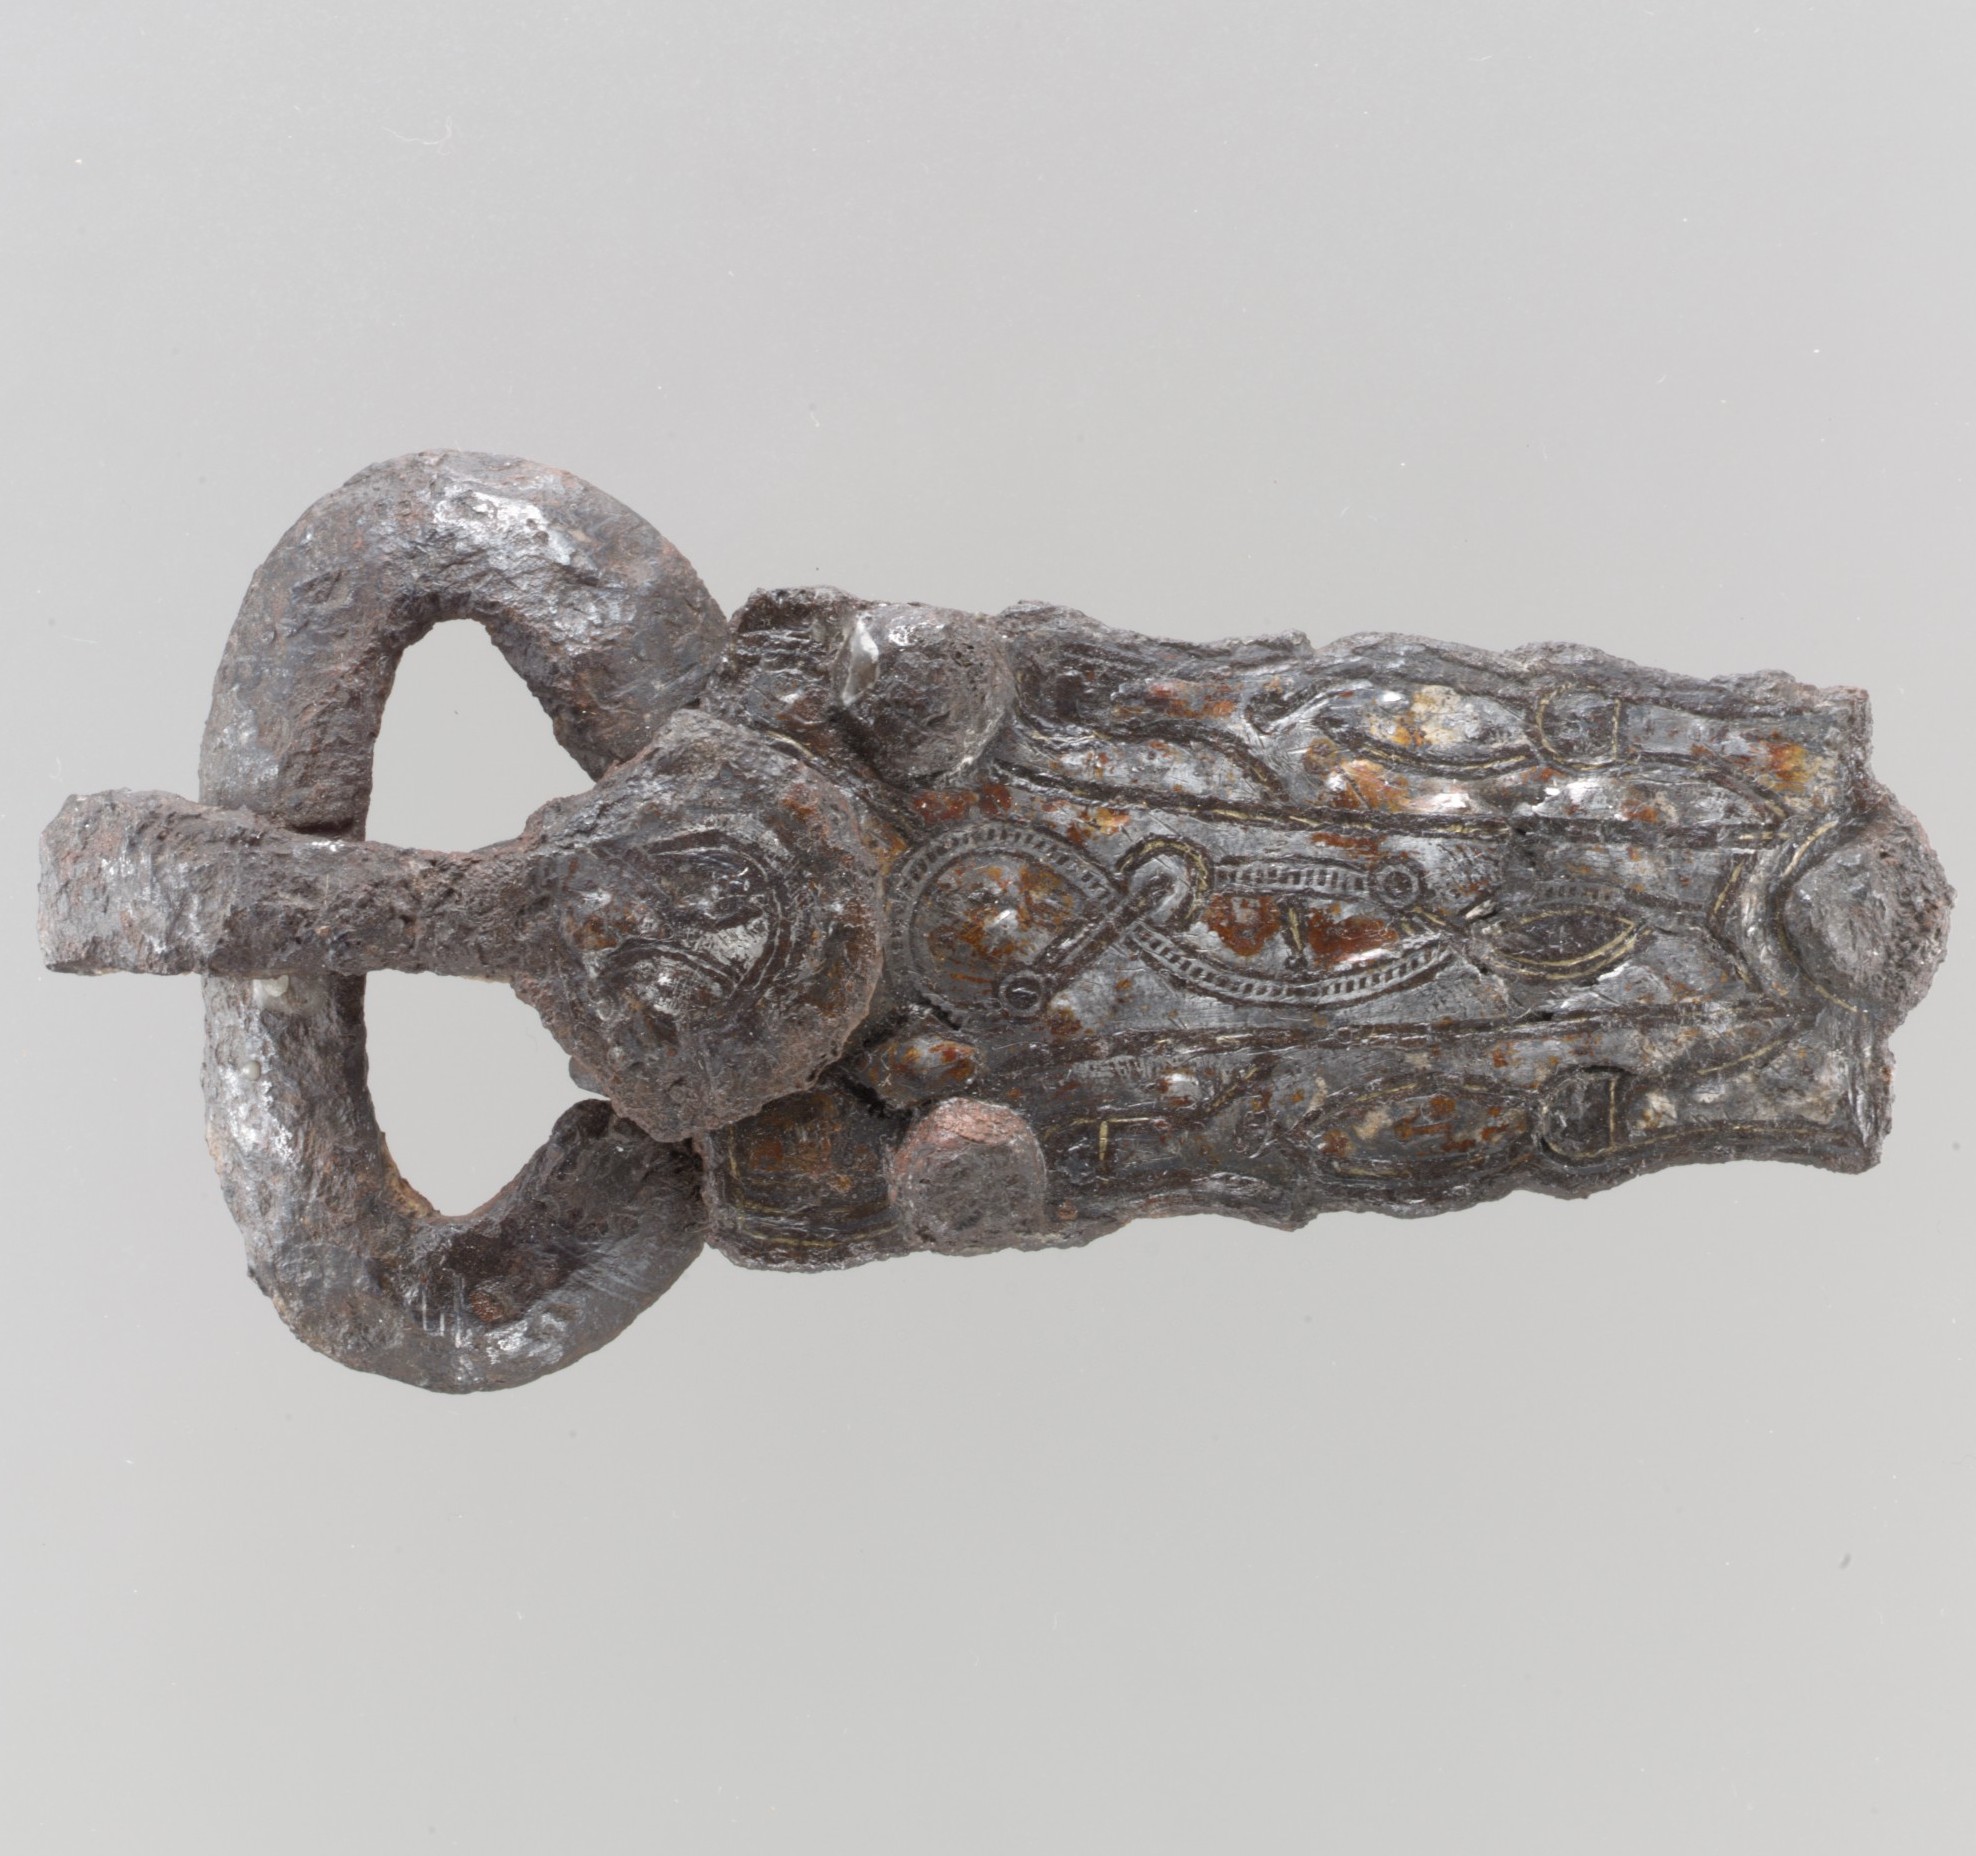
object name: belt buckle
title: Belt Buckle and Plate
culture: frankish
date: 601-700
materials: copper, iron, silver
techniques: inlay